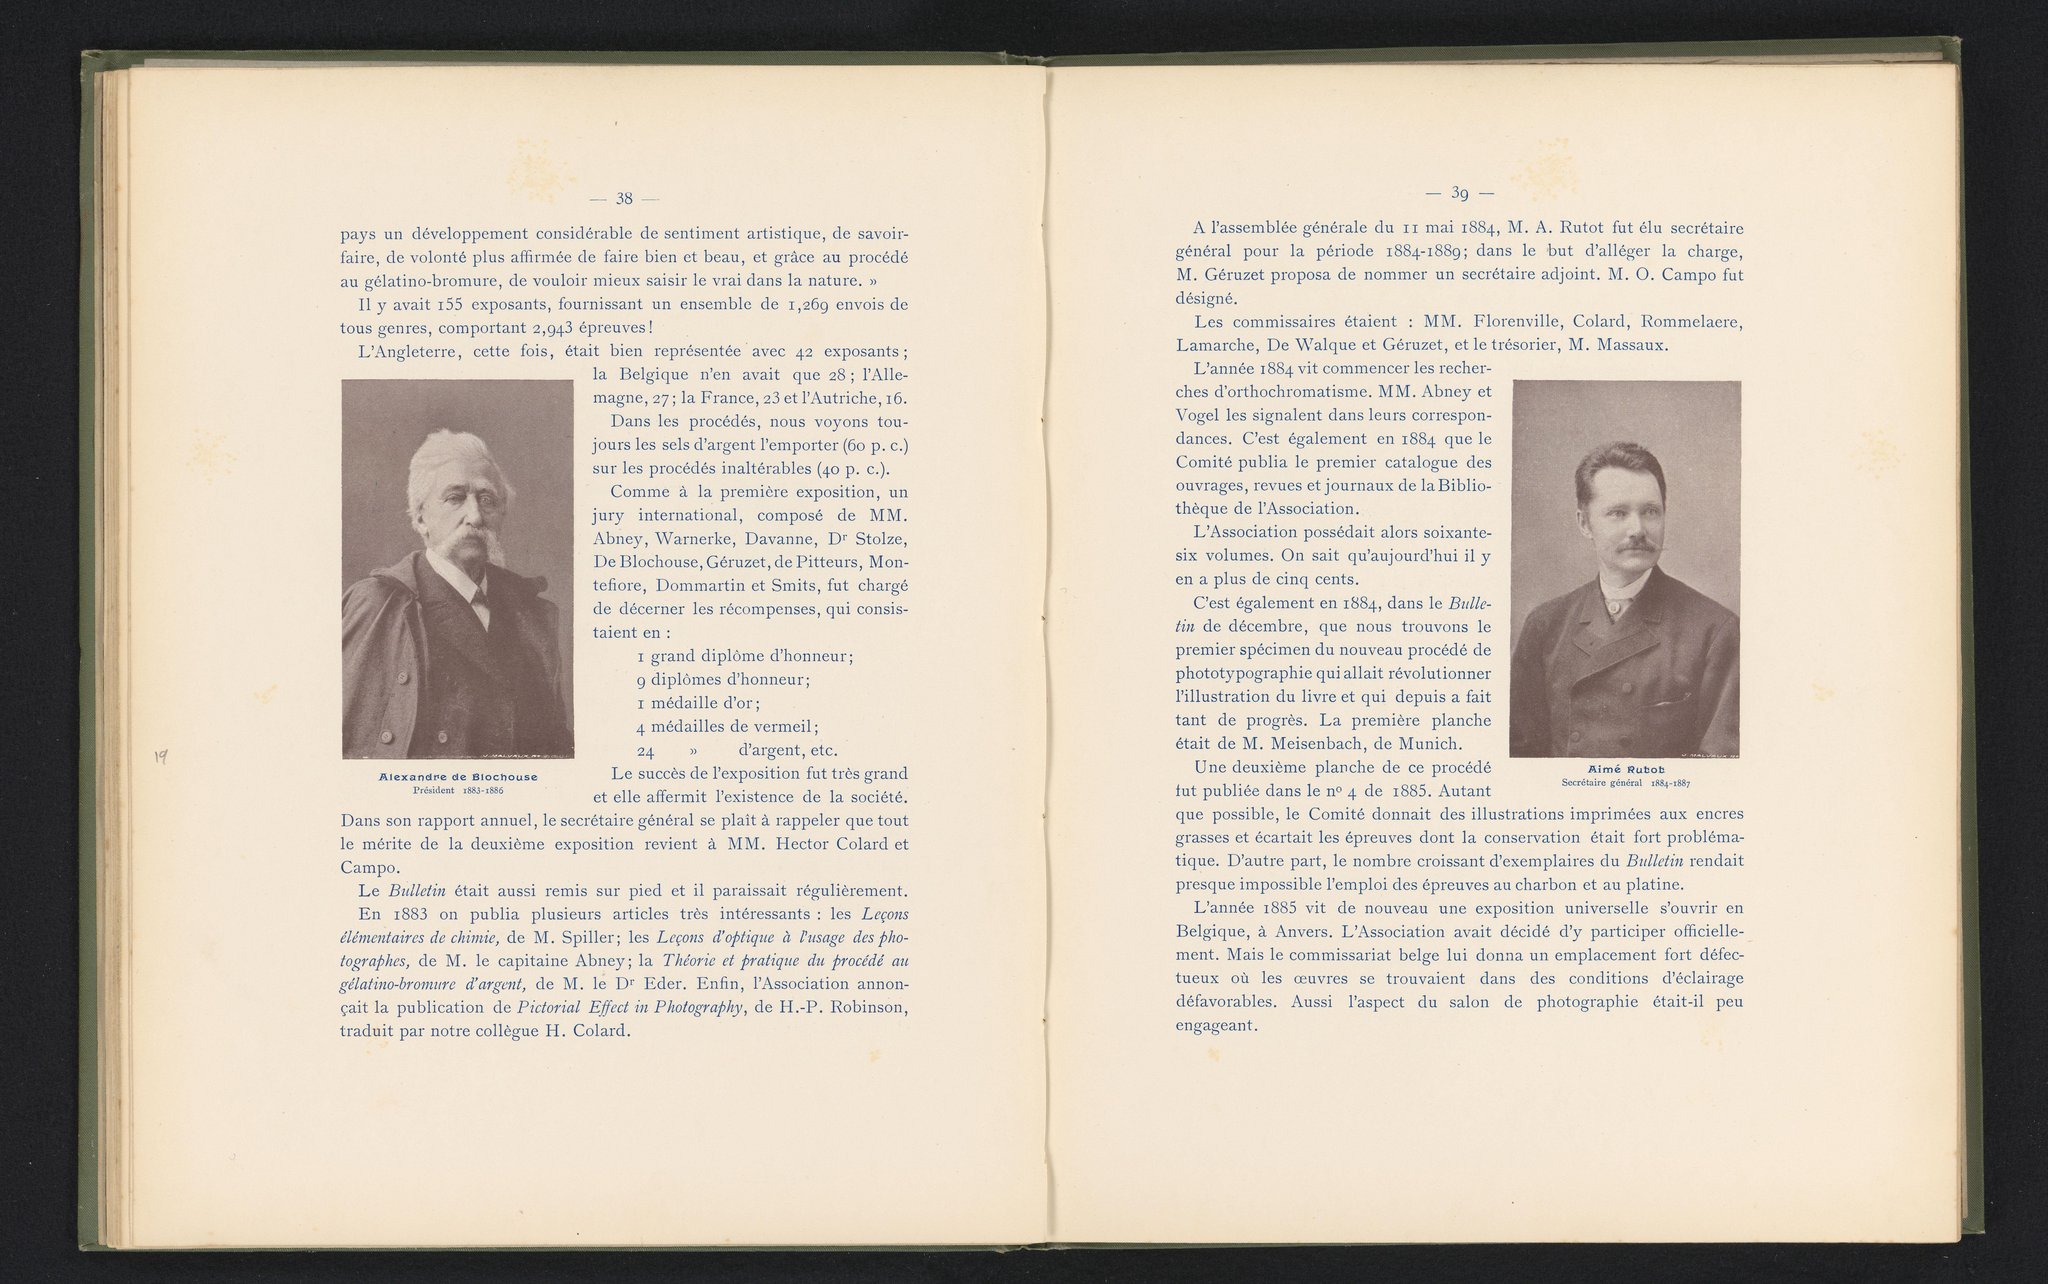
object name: page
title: Portret van Alexandre de Blochouse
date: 1893-1898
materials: paper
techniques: autotype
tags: alexandre de blochouse, historical persons